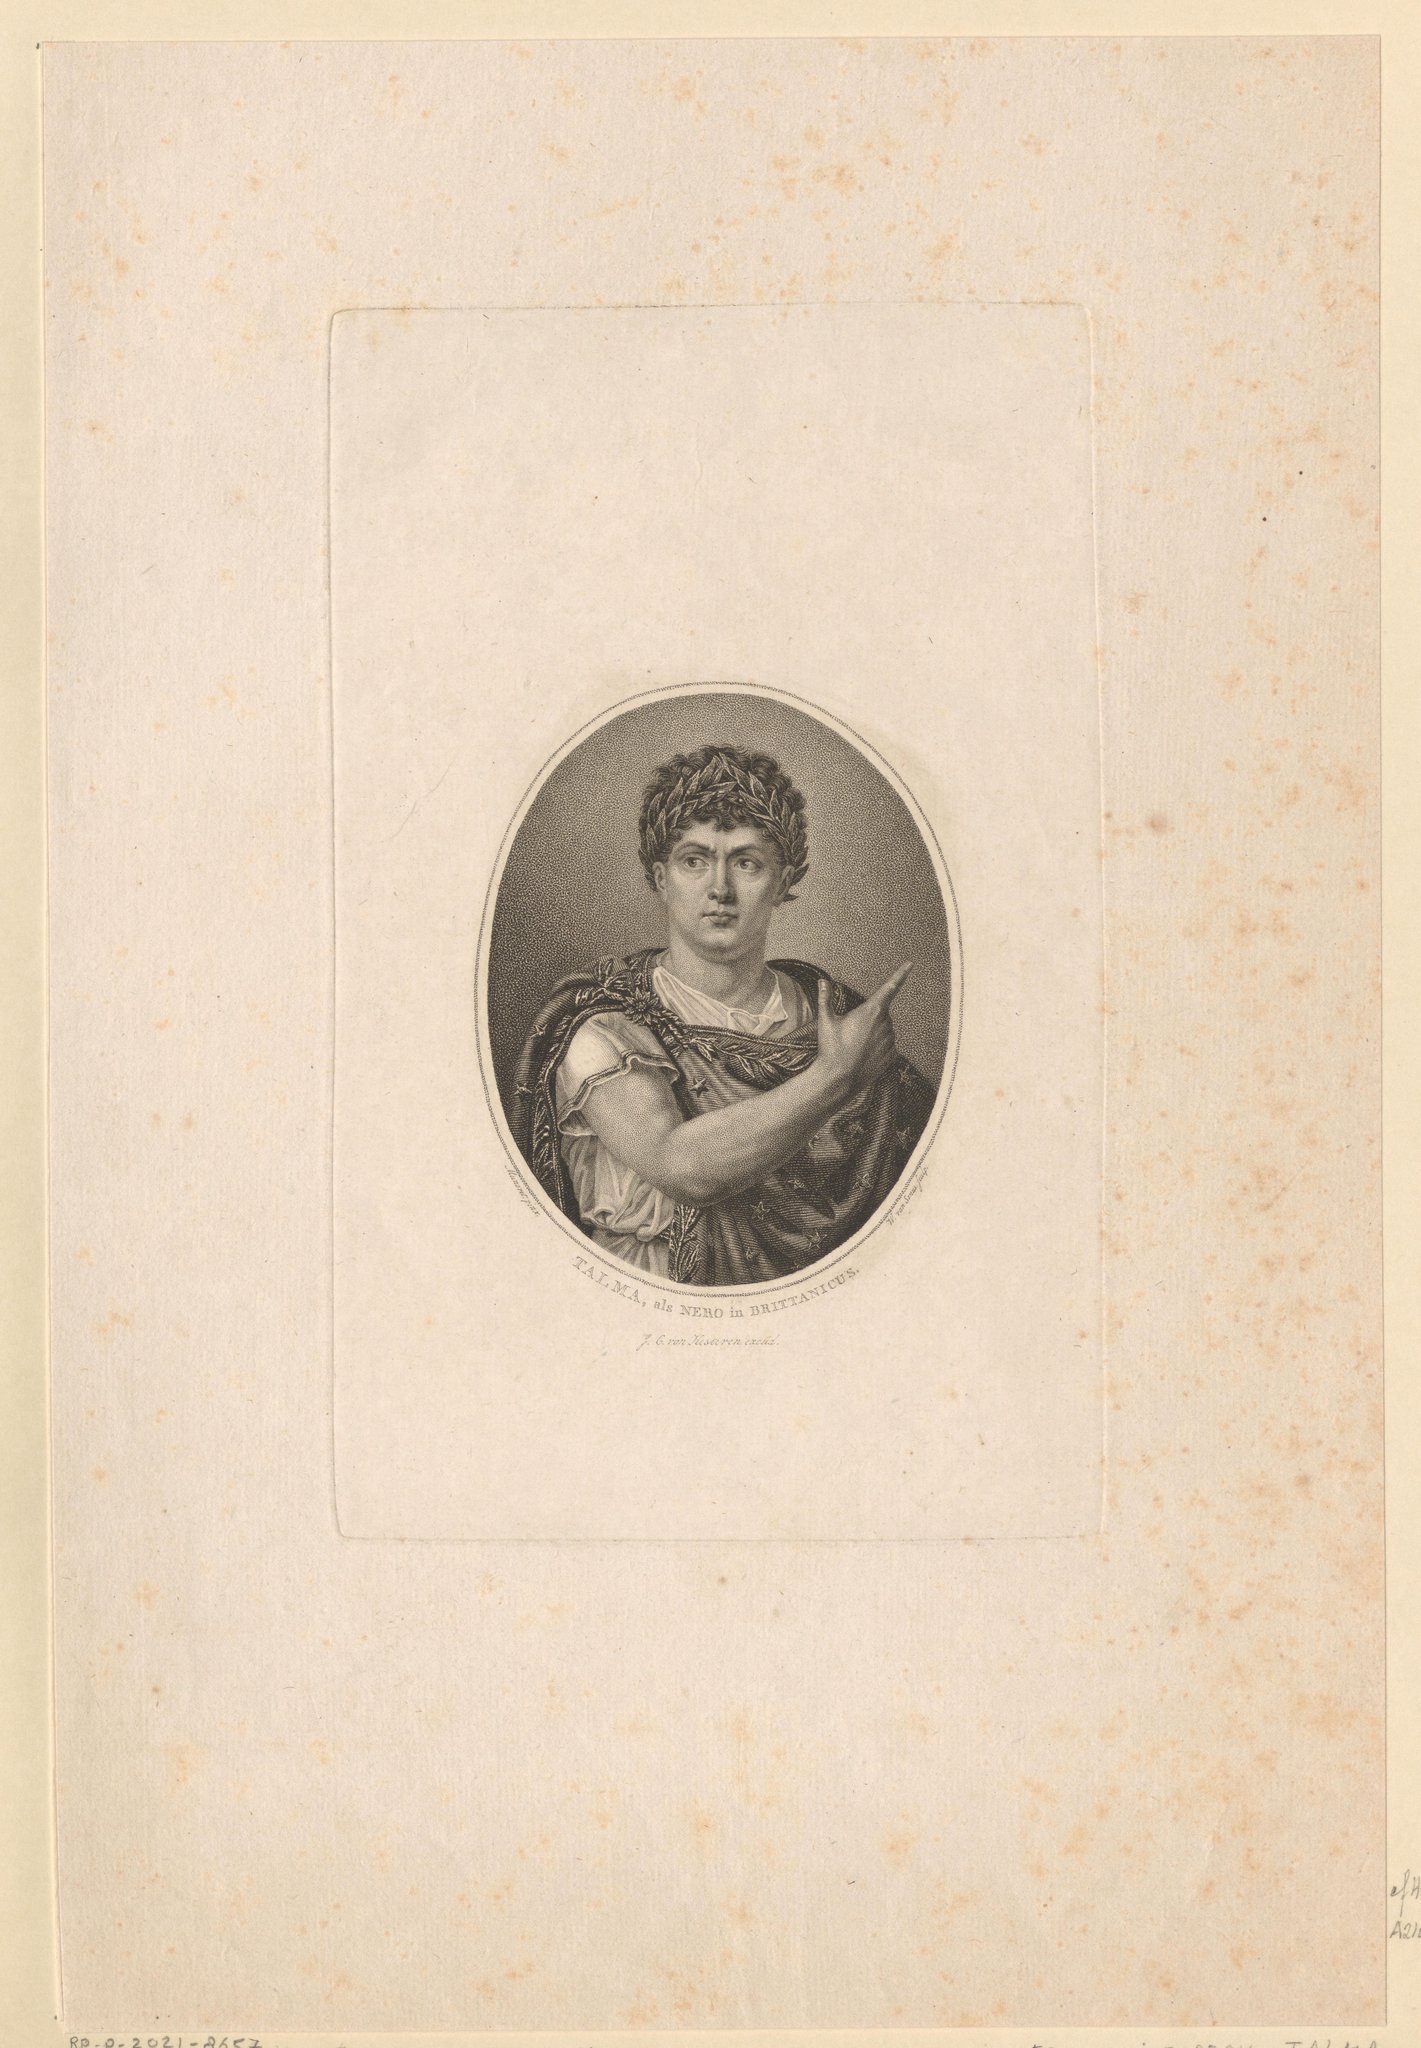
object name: print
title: Portret van François-Joseph Talma als Nero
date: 1818-1851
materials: paper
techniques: etching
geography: amsterdam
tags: paris, historical persons, portrait of actor, actress, (story of) nero, the roman emperor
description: In het toneelstuk Brittanicus van Racine.